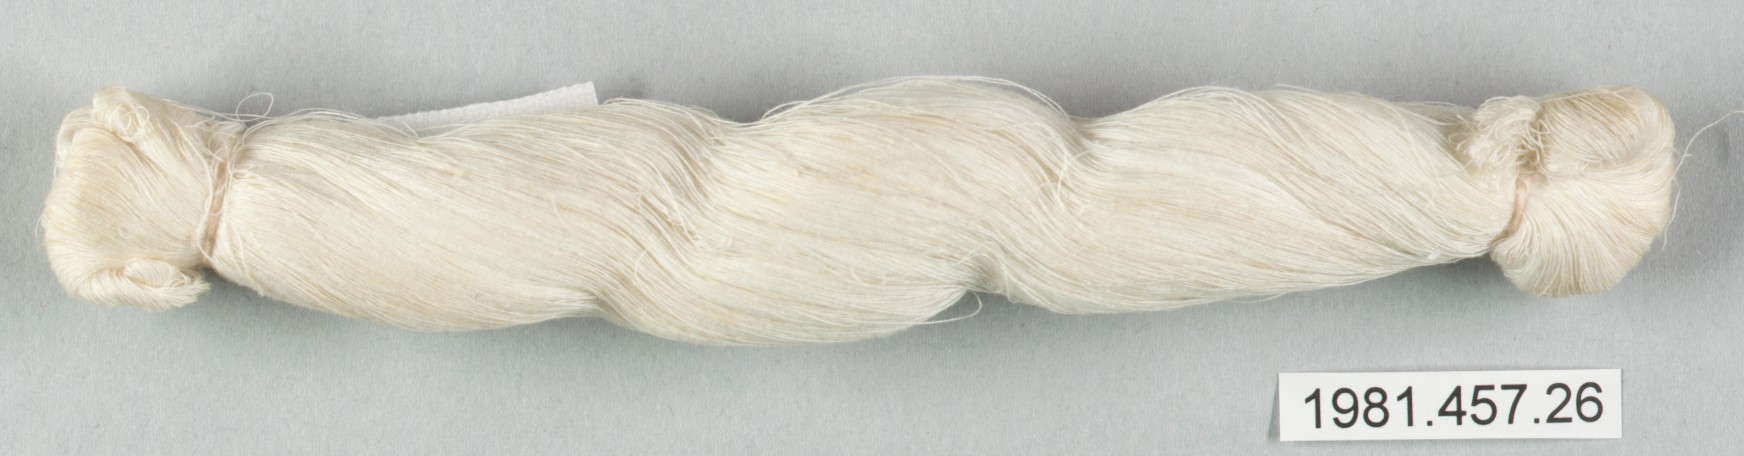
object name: skein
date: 1840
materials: cotton